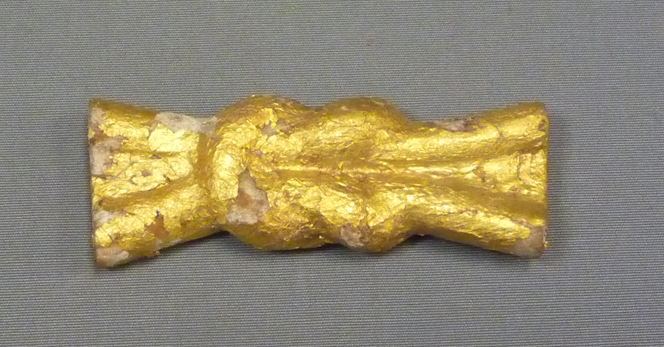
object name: model knot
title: Model Knot from the Foundation Deposit for Hatshepsut's Tomb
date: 1479-1458 BCE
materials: gold leaf, wood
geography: egypt